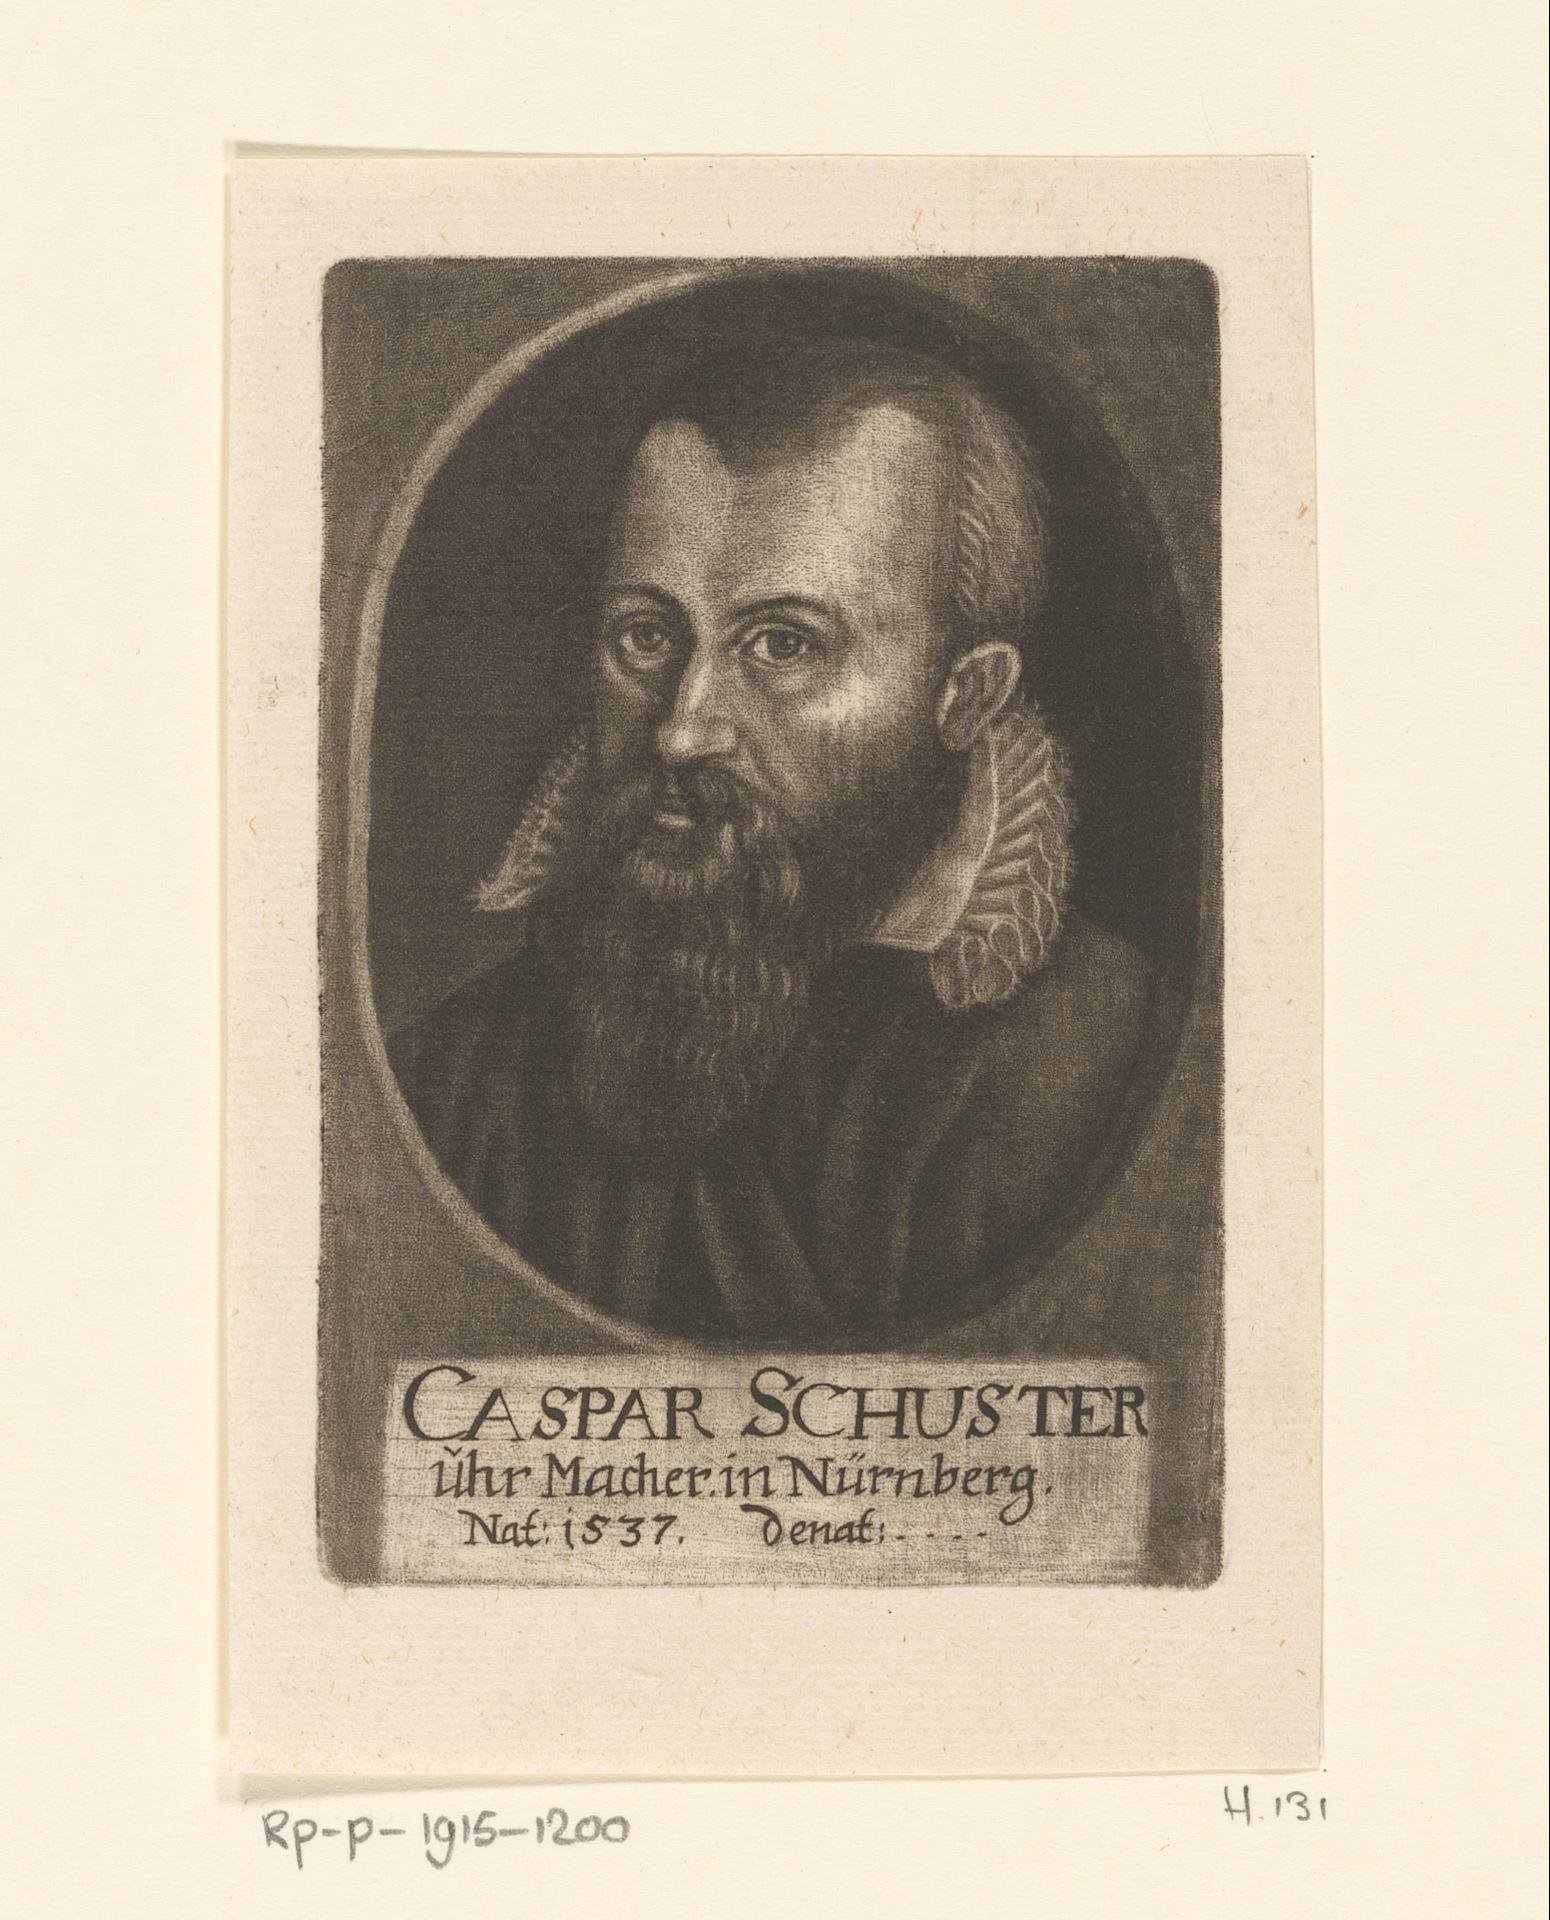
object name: print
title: Portret van Caspar Schuster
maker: georg fennitzer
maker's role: print maker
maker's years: 1646-1722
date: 1656-1722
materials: paper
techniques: mezzotint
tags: historical persons, watchmaker, clockmaker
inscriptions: collector's mark: Lugt 2228